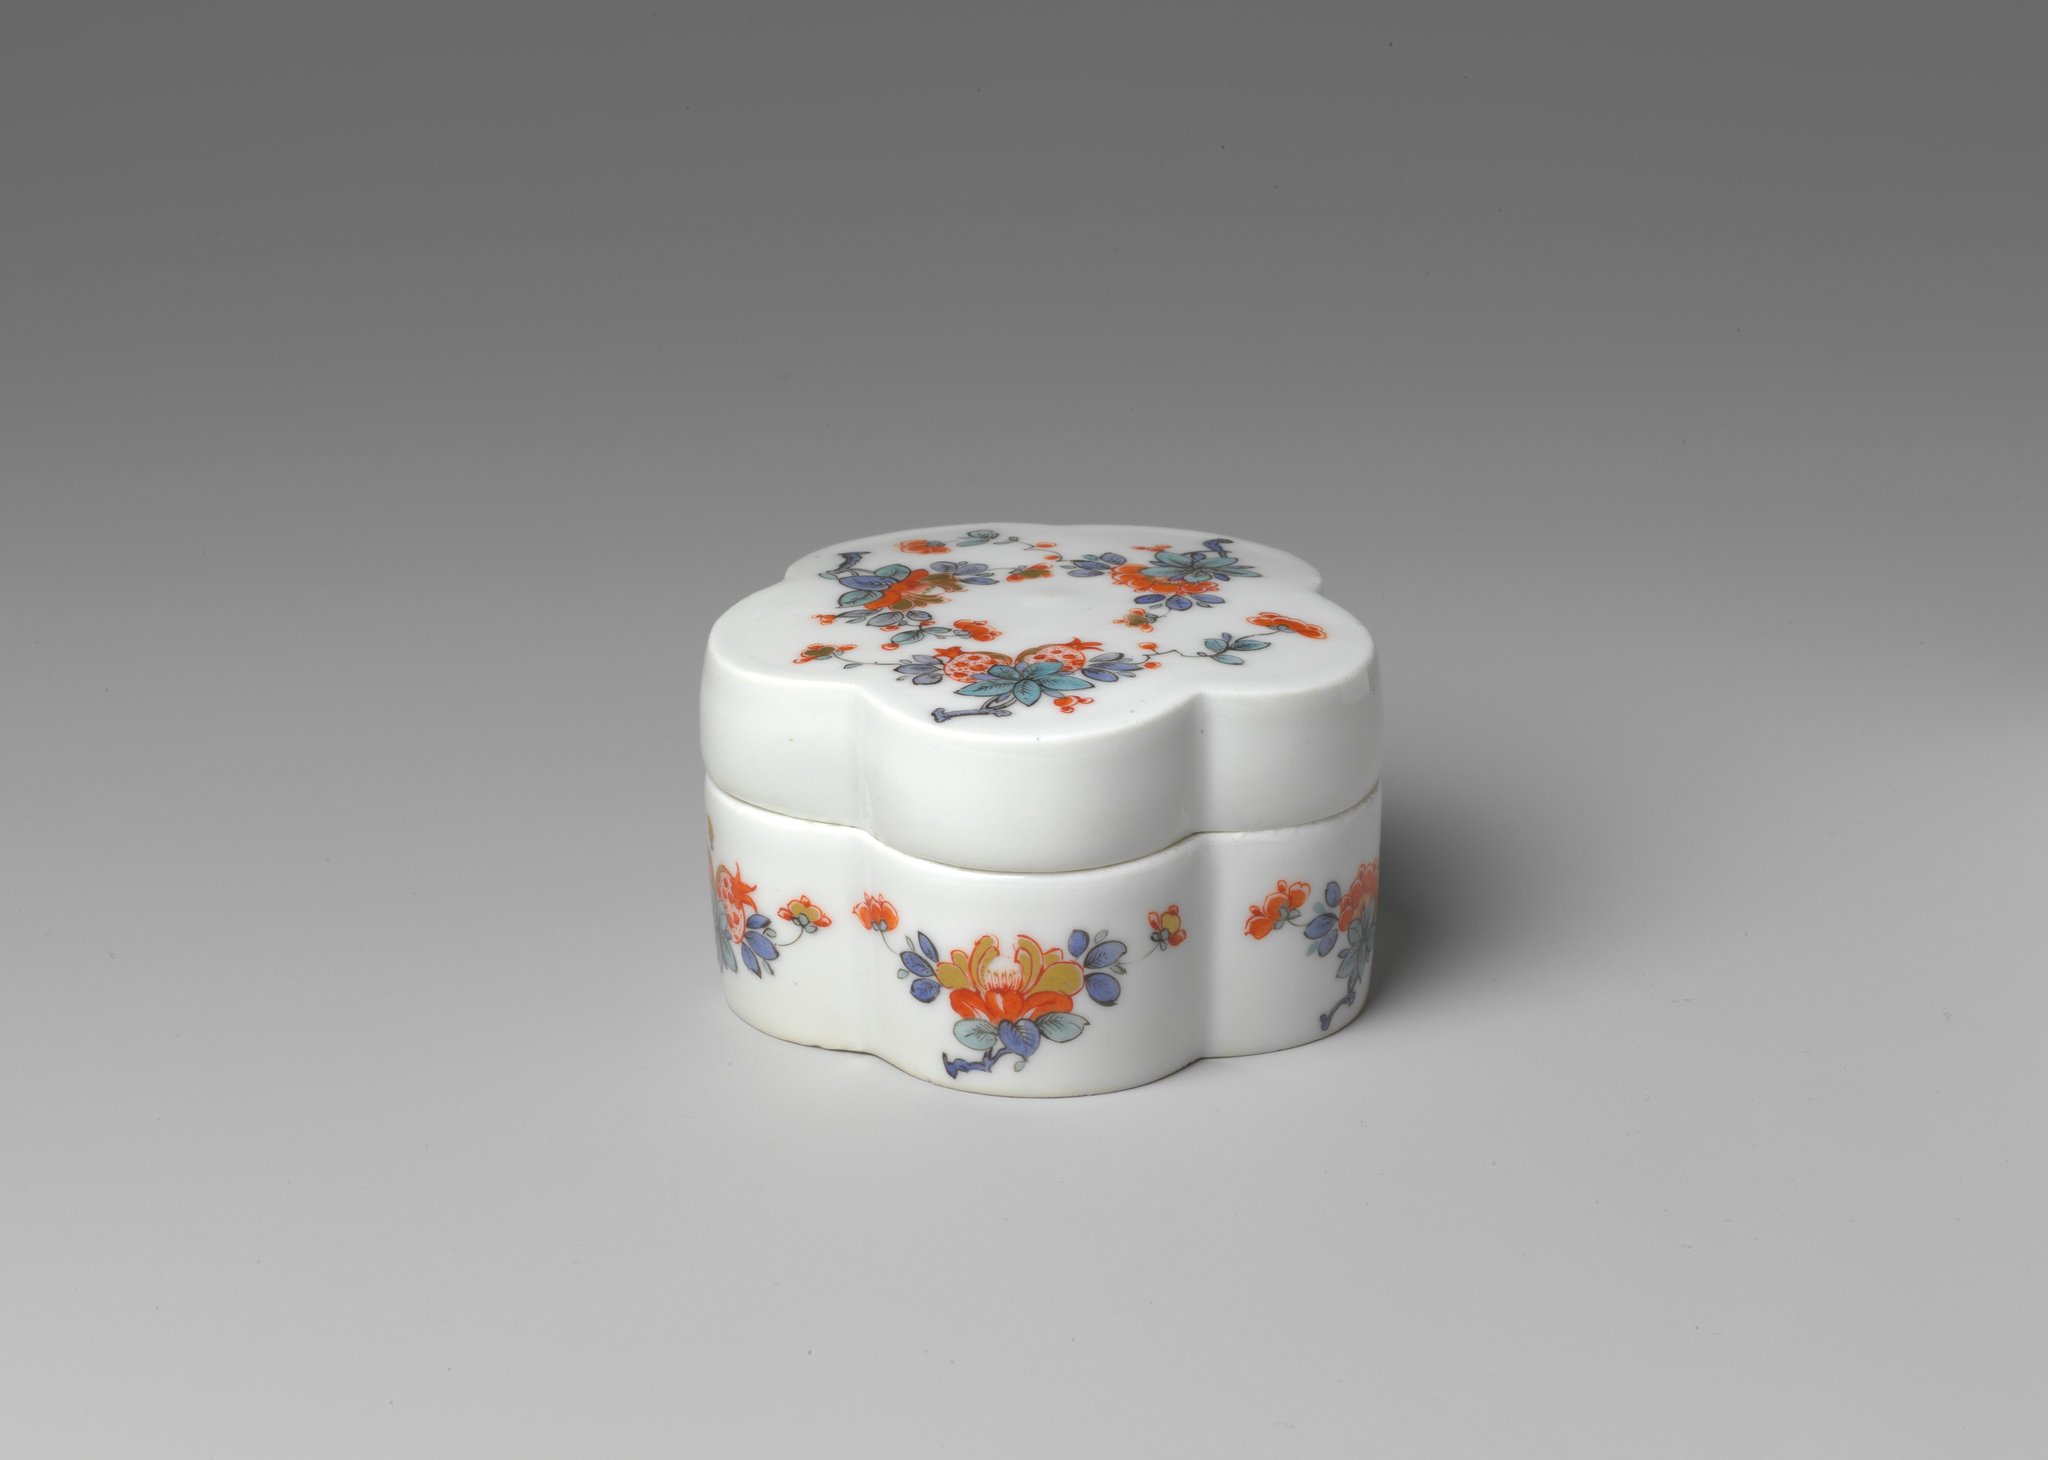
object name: toilet box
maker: meissen manufactory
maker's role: manufactory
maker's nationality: german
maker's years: 1710-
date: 1730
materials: hard paste porcelain